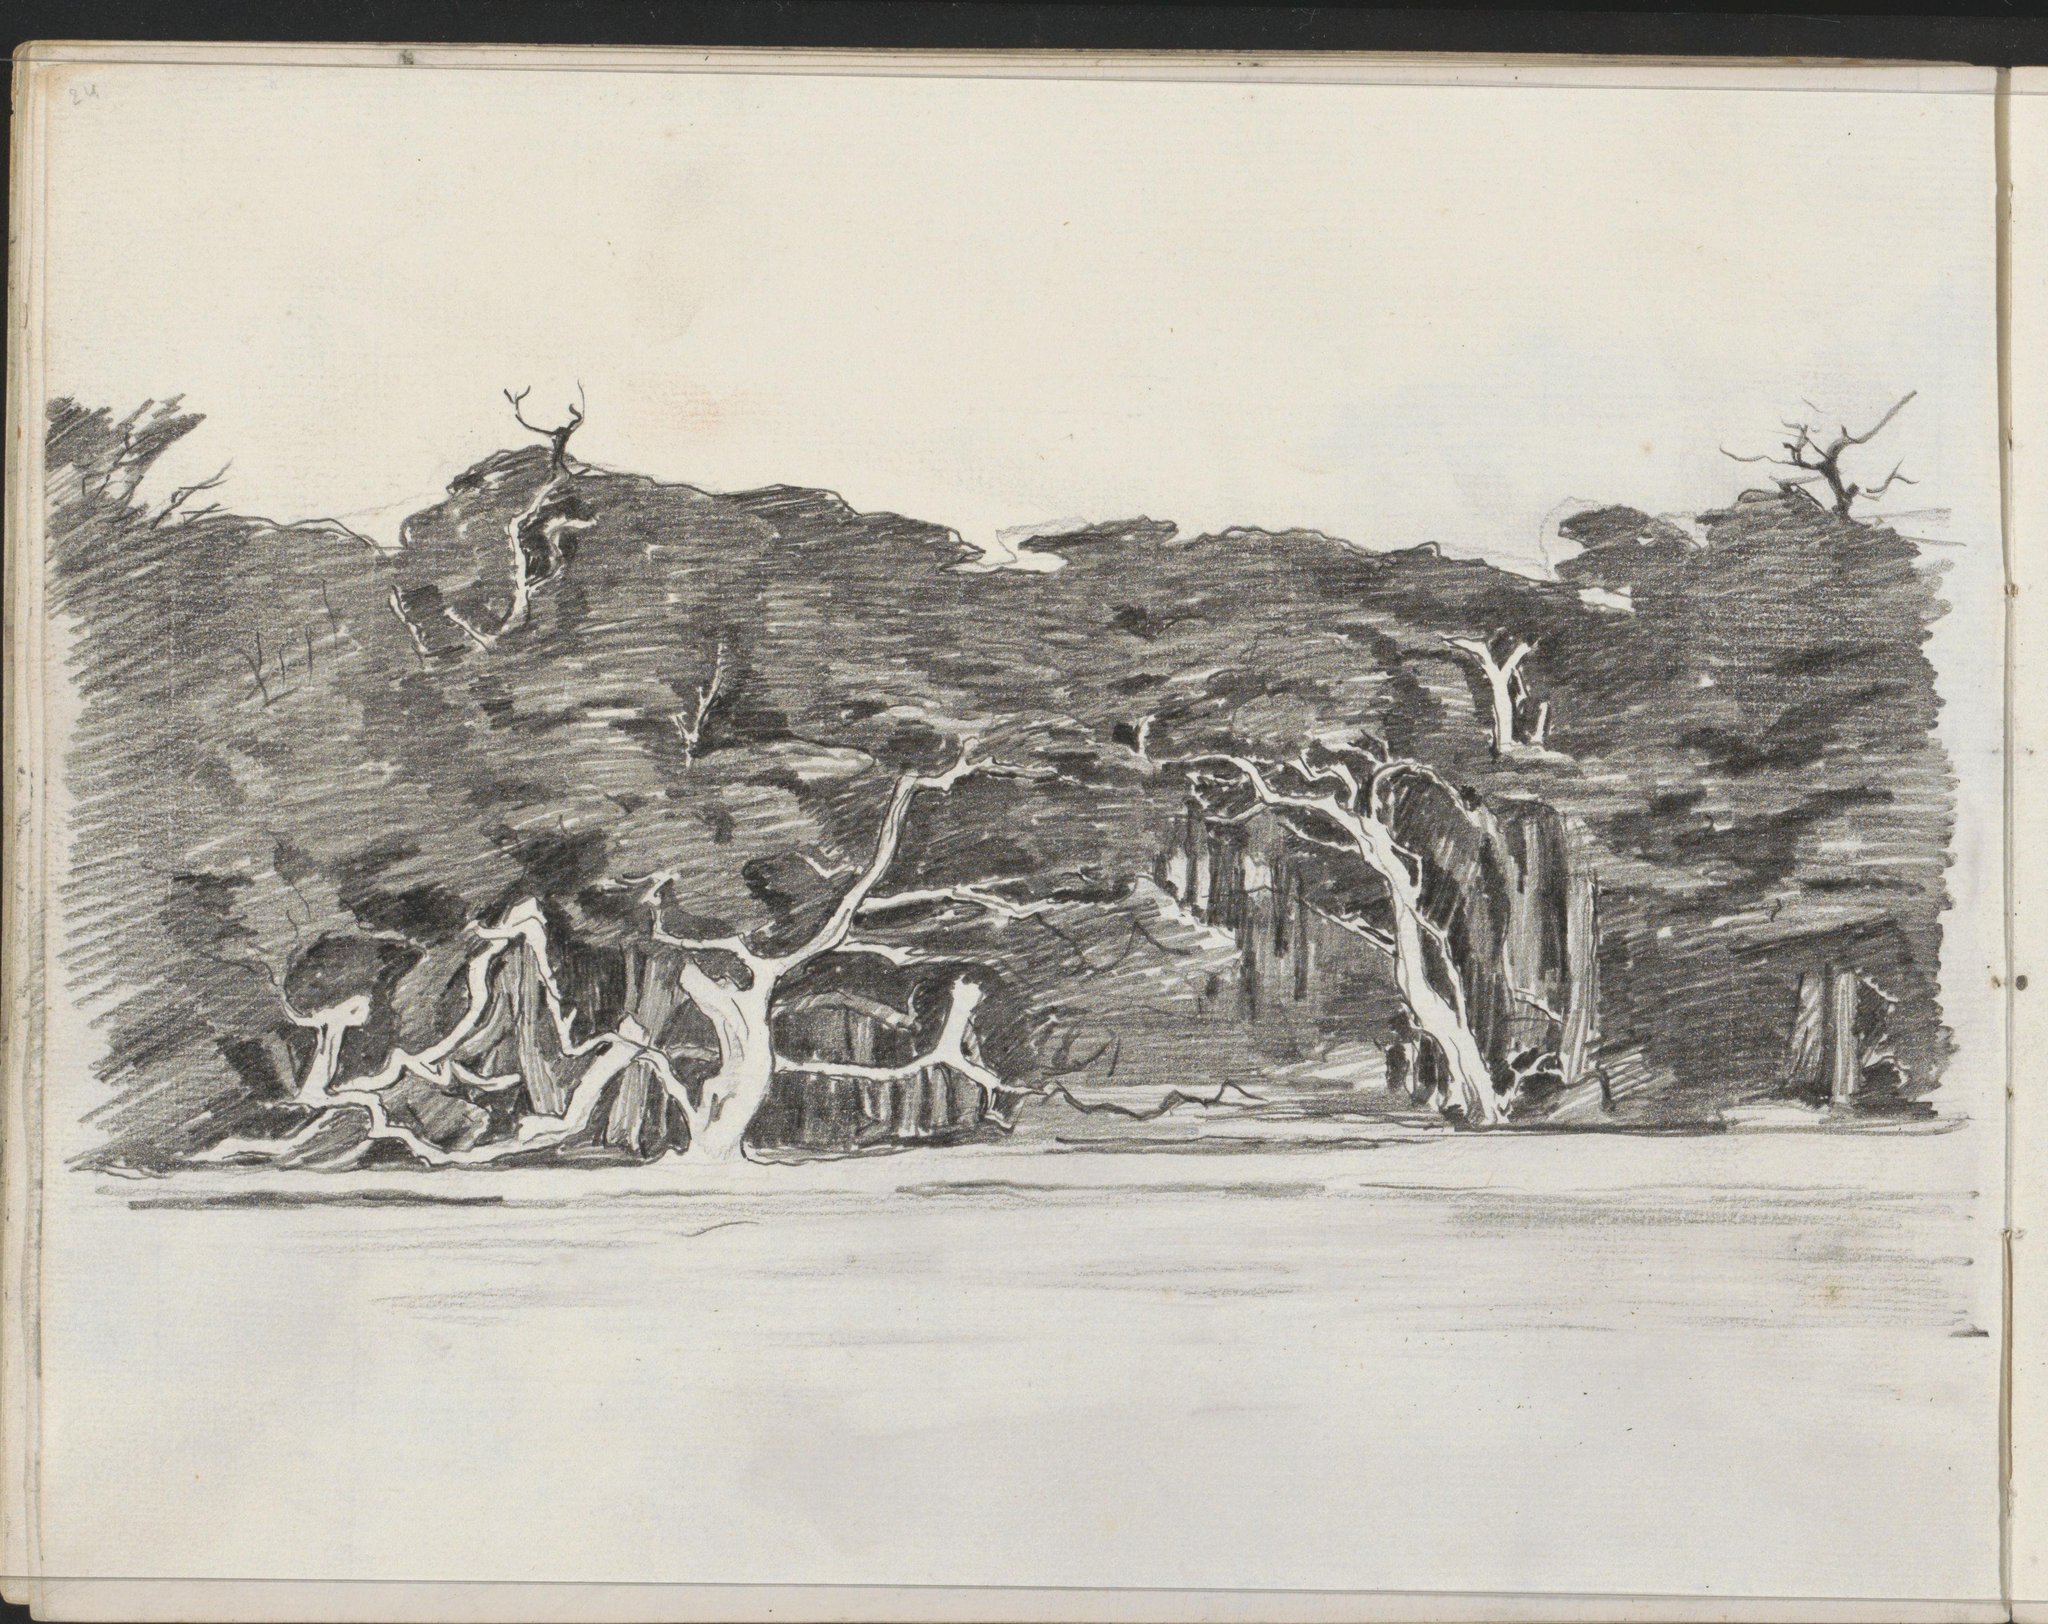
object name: sketchbook leaf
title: Kustgezicht met bomen, mogelijk bij St. Andrews te Canada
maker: willem witsen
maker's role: draughtsman, painter, print maker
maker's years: 1860-1923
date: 1915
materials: paper, pencil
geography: st. andrews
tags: trees, rocky coast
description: Pagina 24 uit een schetsboek met 18 bladen.